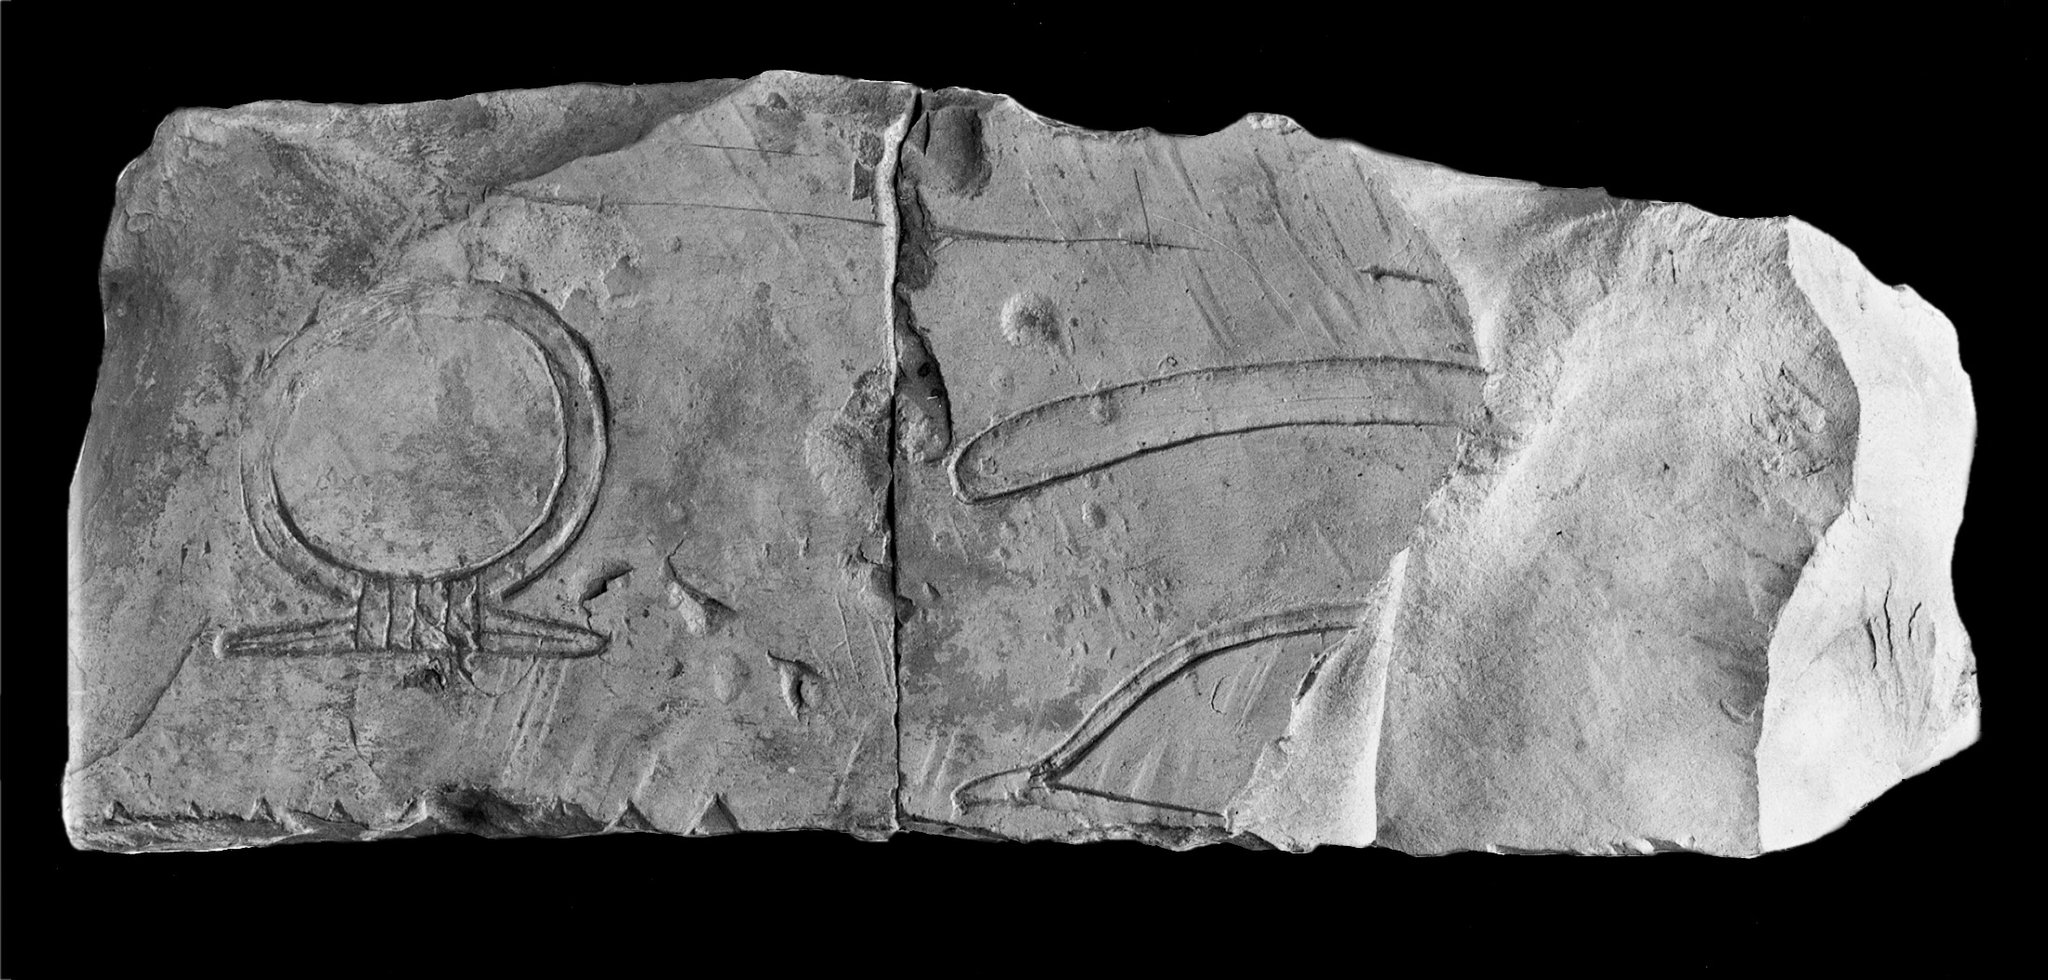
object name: relief, tomb of nespekashuty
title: Sunk relief fragment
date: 664-610 BCE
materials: limestone, varnish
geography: egypt